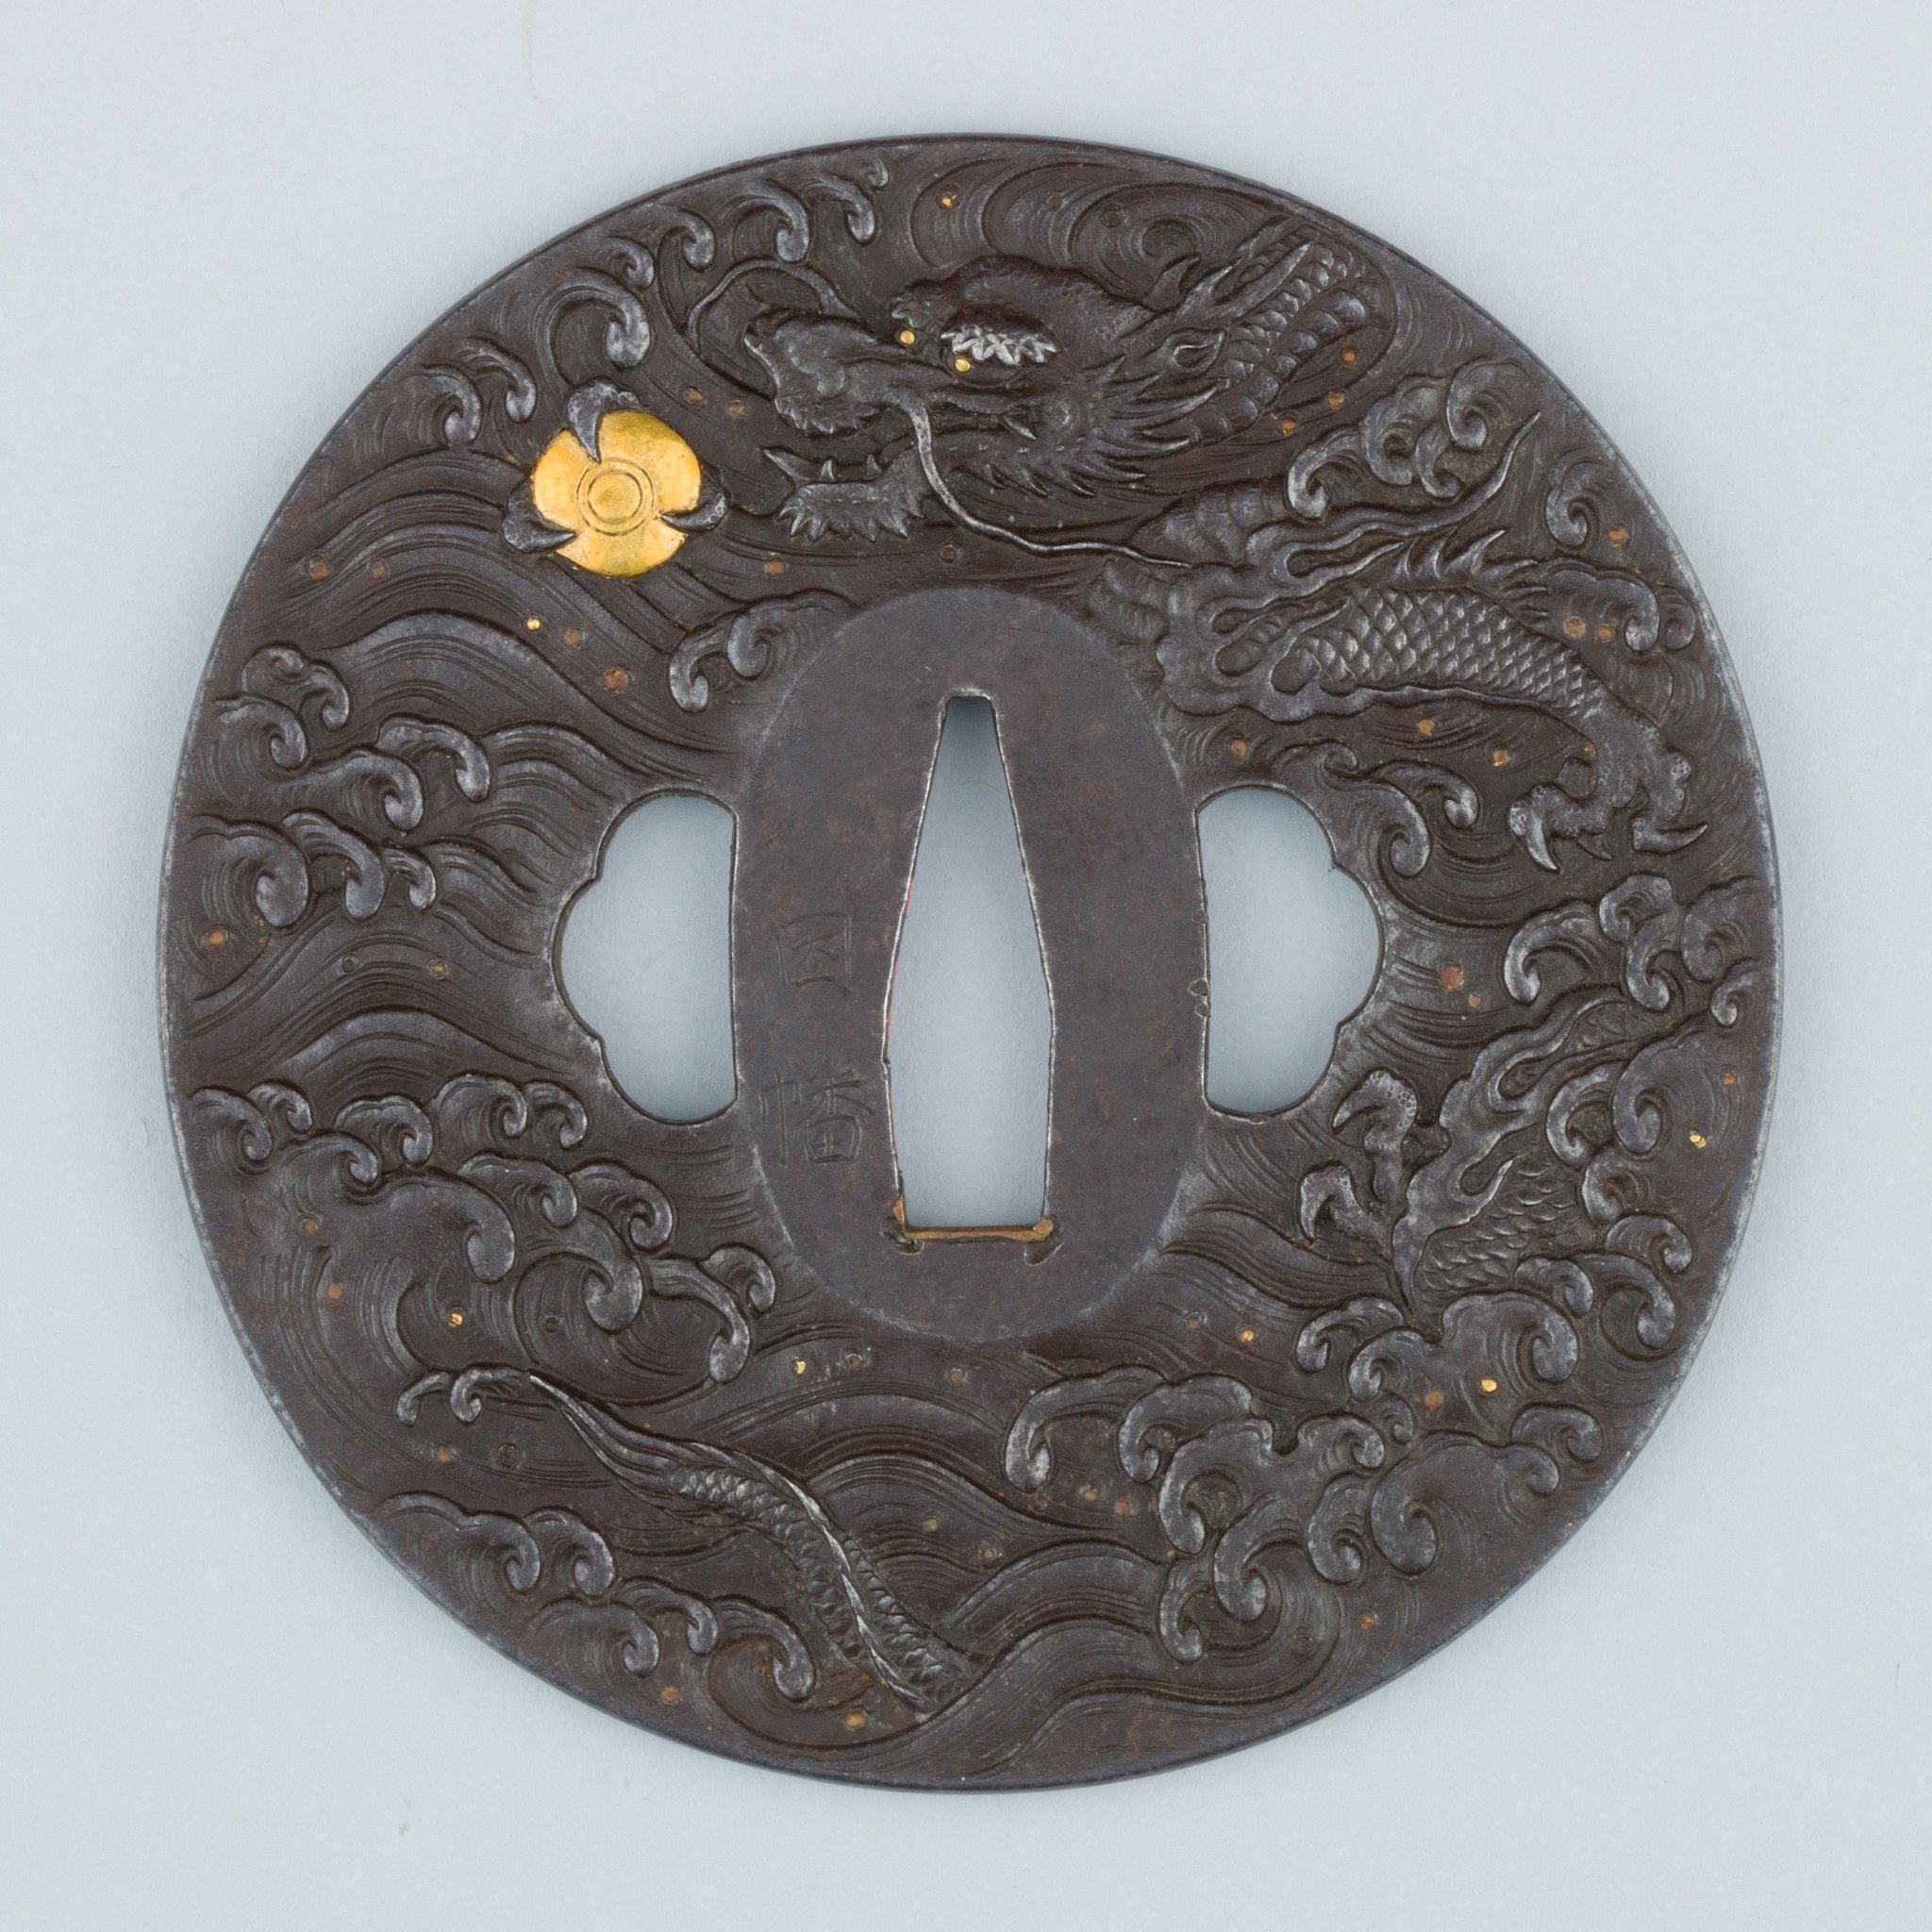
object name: sword guard tsuba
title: Sword Guard (Tsuba)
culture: japanese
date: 1701-1800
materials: copper, gold, iron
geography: japan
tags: dragons